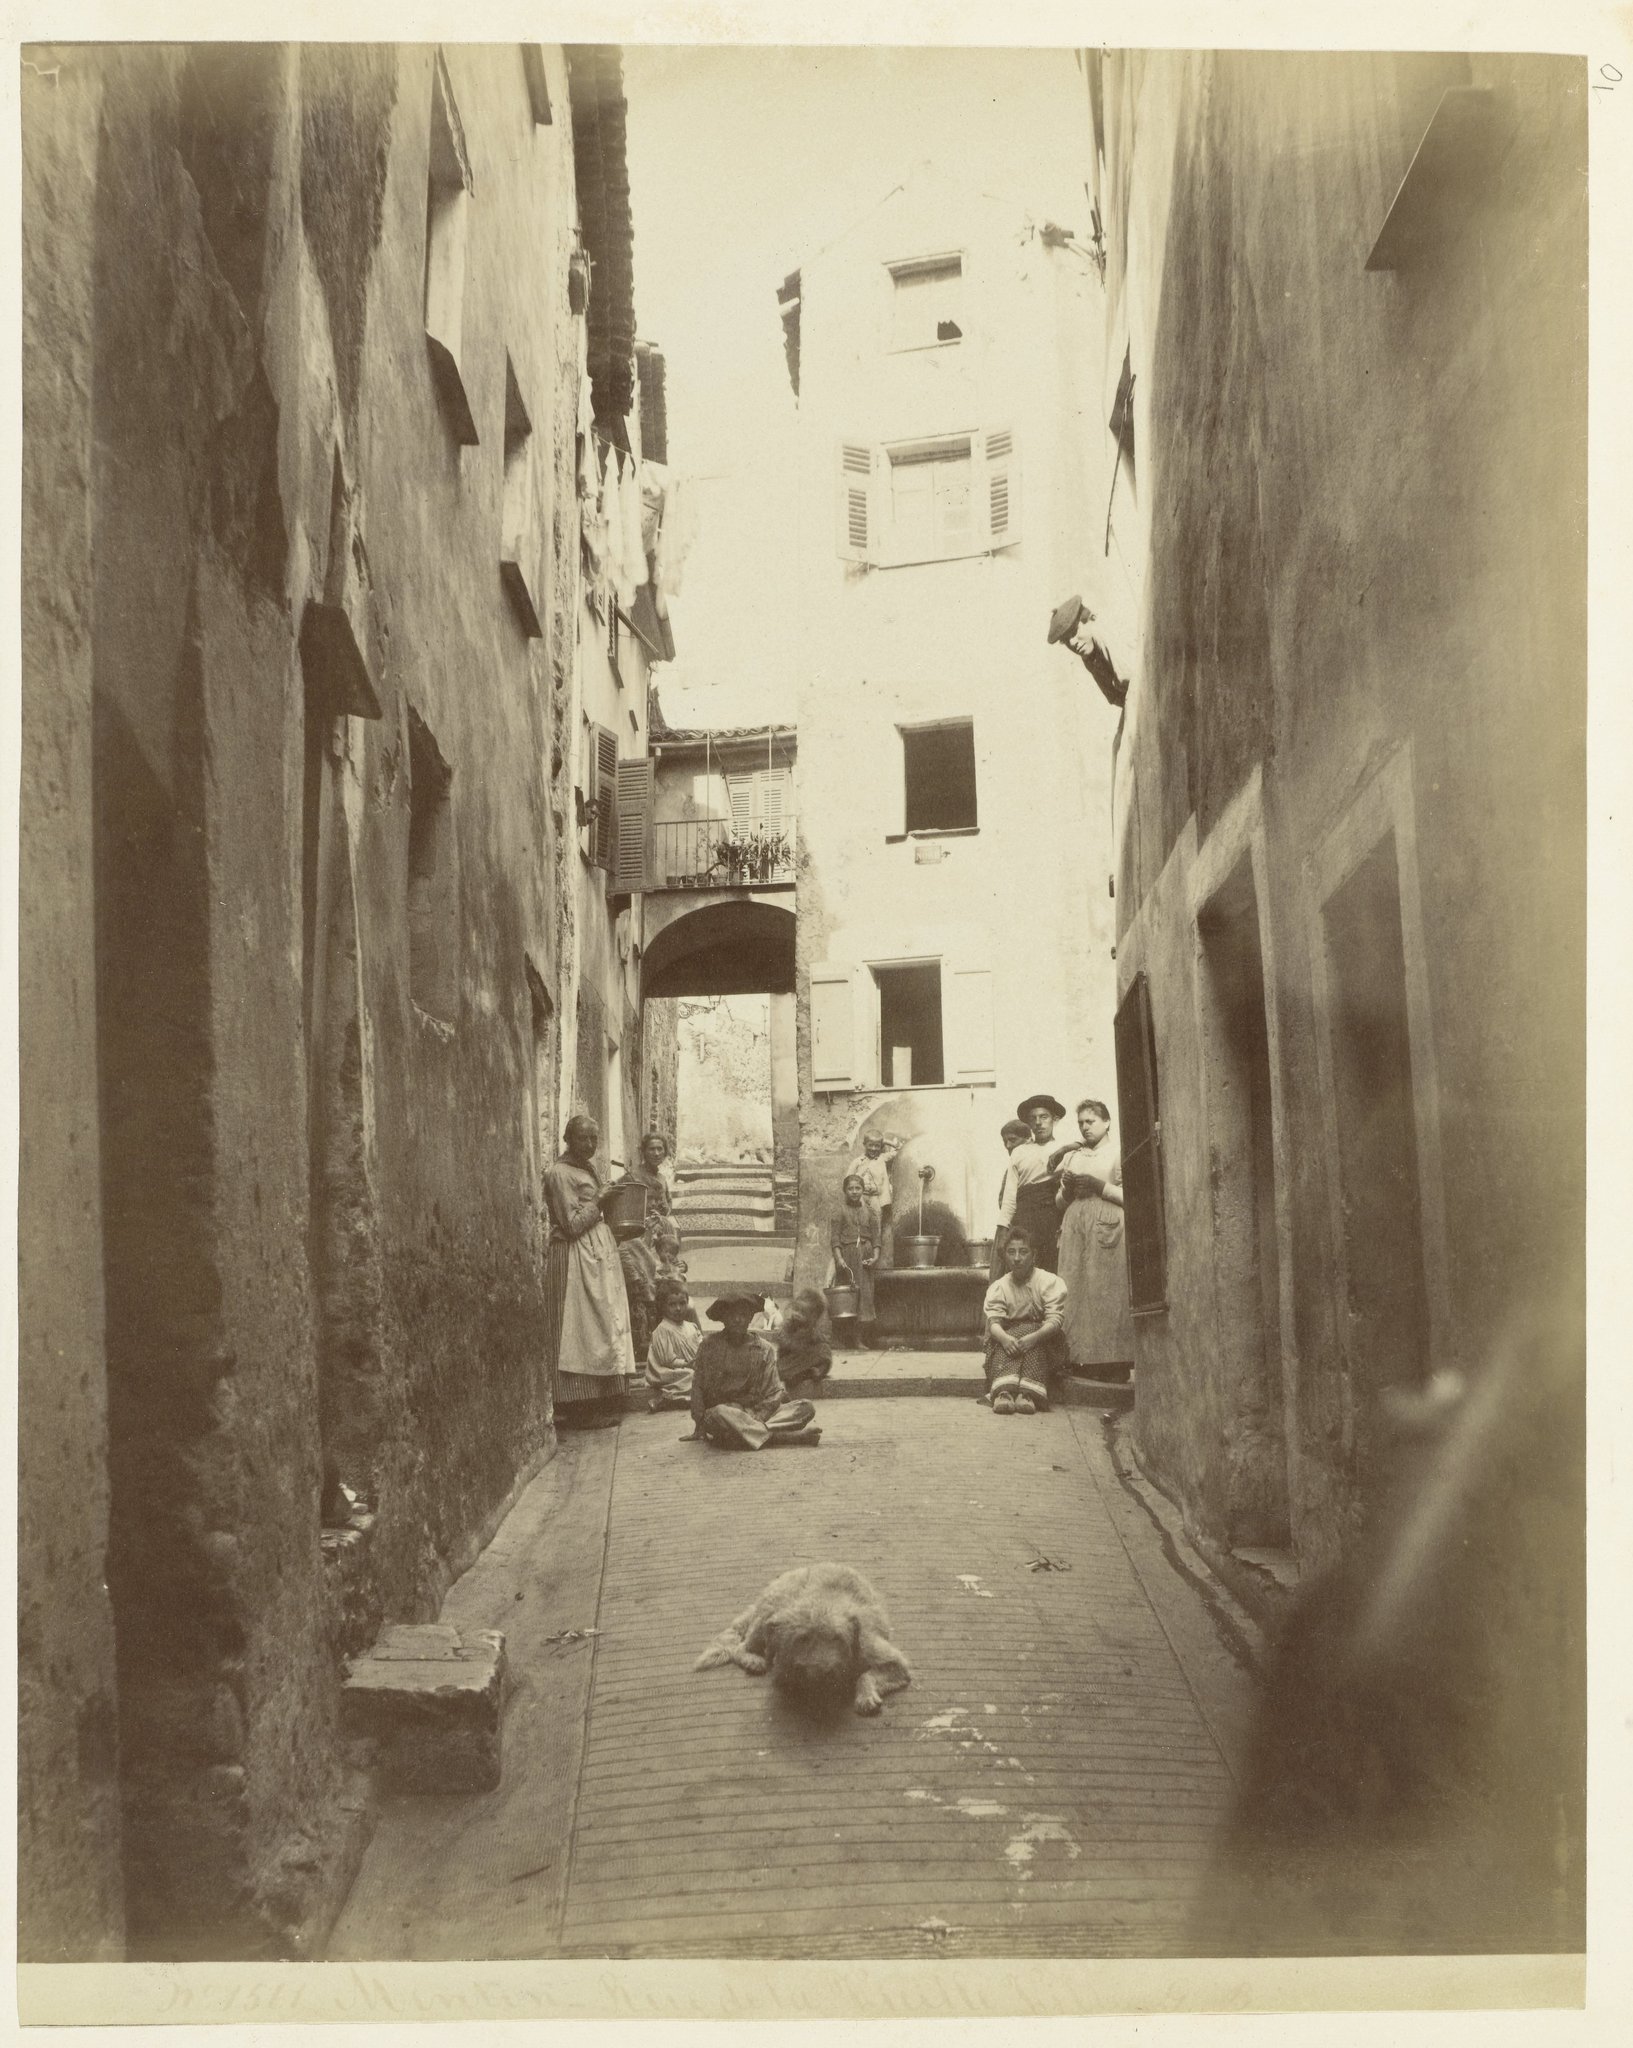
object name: photograph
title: No 1511 Menton Rue de la huil (...)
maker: henry pauw van wieldrecht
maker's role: fotograaf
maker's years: 1863-1912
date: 1886-1896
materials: cardboard, photographic support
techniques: albumen print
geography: france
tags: menton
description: Een smalle arbeidersstraat in in Menton met kinderen en vrouwen in werkkleding. Achter in de straat is een waterpunt waar mensen emmers met water vullen.